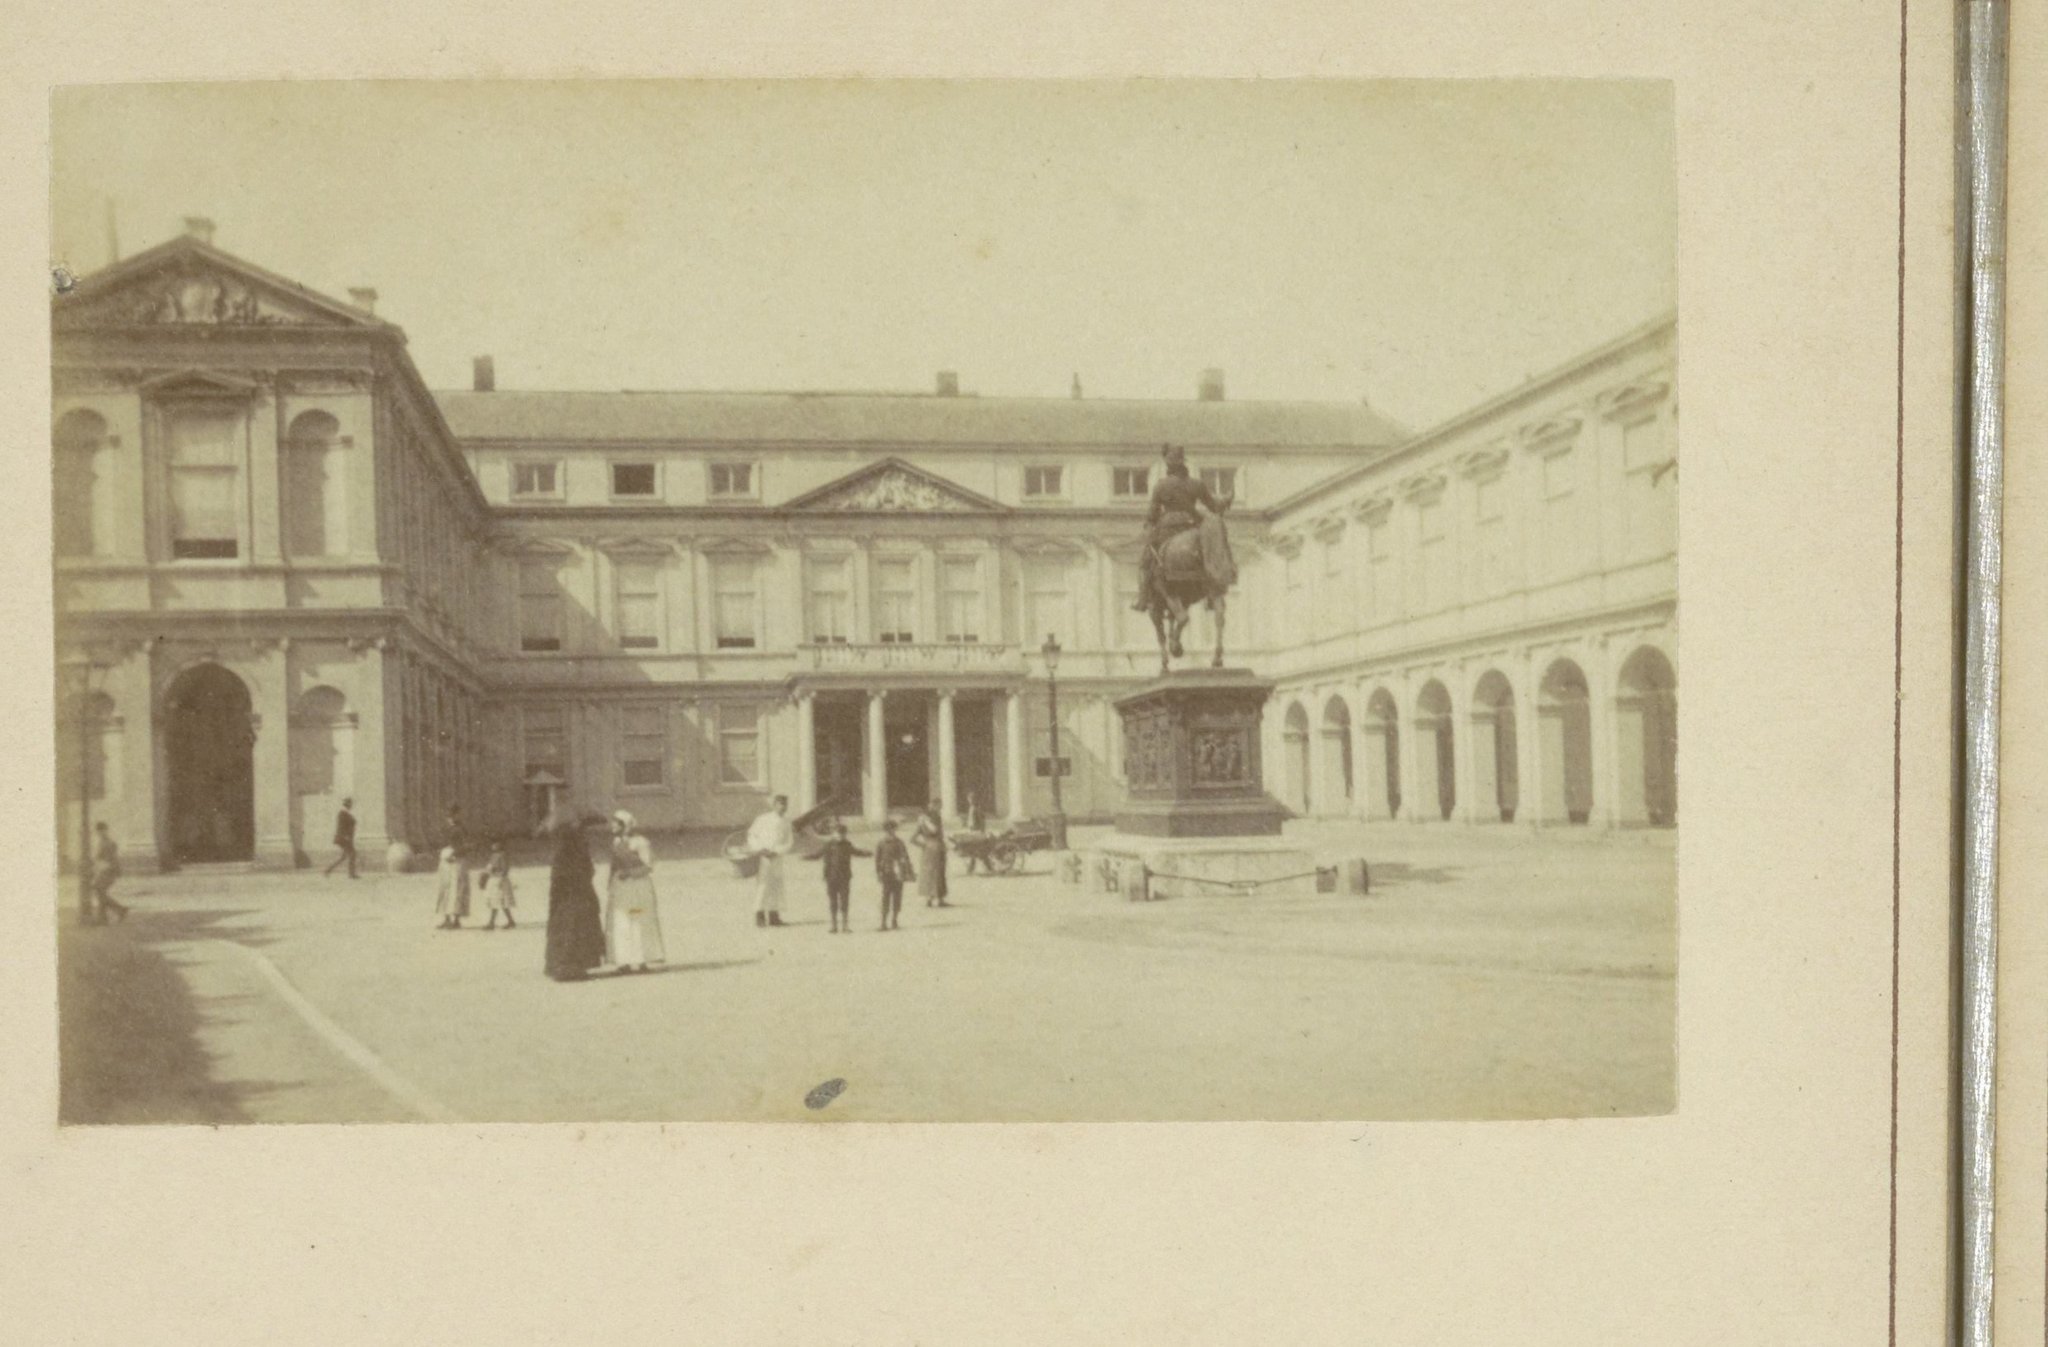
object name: album leaf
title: s' Gravenhage. Het Paleis van de Koningin.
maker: andries jager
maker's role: publisher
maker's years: 1825-1905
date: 1860-1900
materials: cardboard, photographic support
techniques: albumen print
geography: the hague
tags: palace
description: Onderdeel van Fotoalbum met opnames van steden in Noord- en Zuid-Holland en Utrecht.